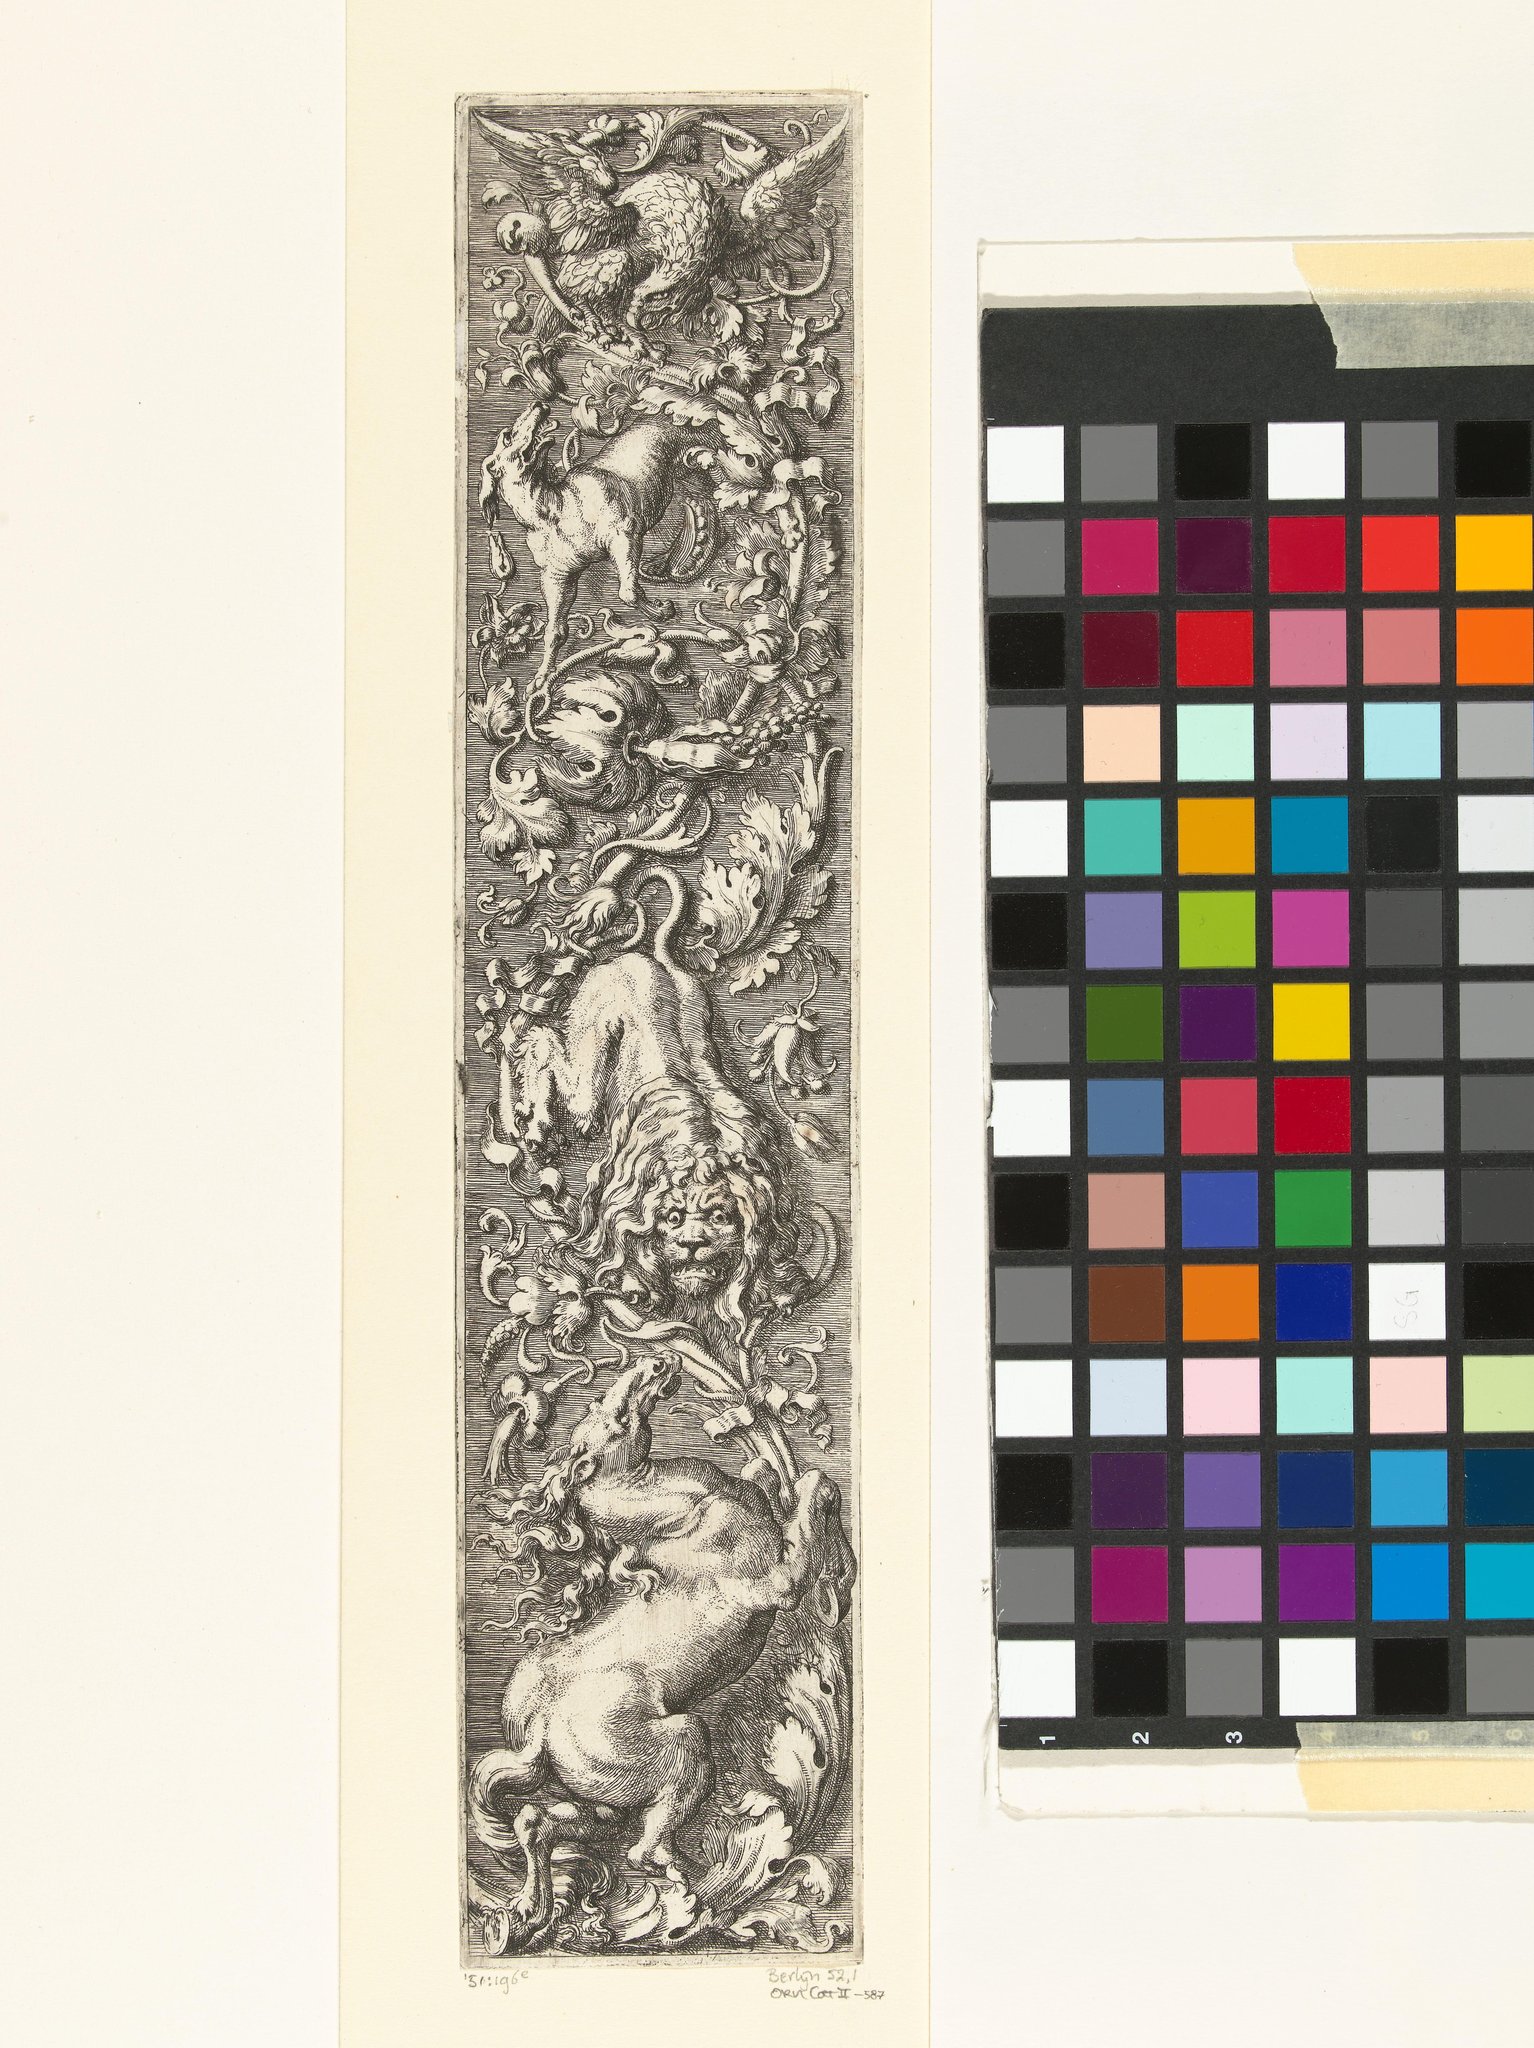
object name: ornament print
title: Pilasterdecoratie met dieren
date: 1645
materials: paper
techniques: etching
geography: london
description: Bladrank met bloemen, waartussen van beneden naar boven de volgende dieren te zien zijn: een steigerend paard, een leeuw, een hond en een adelaar. Blad uit serie bestaande uit een titelblad en negen ongenummerde bladen.